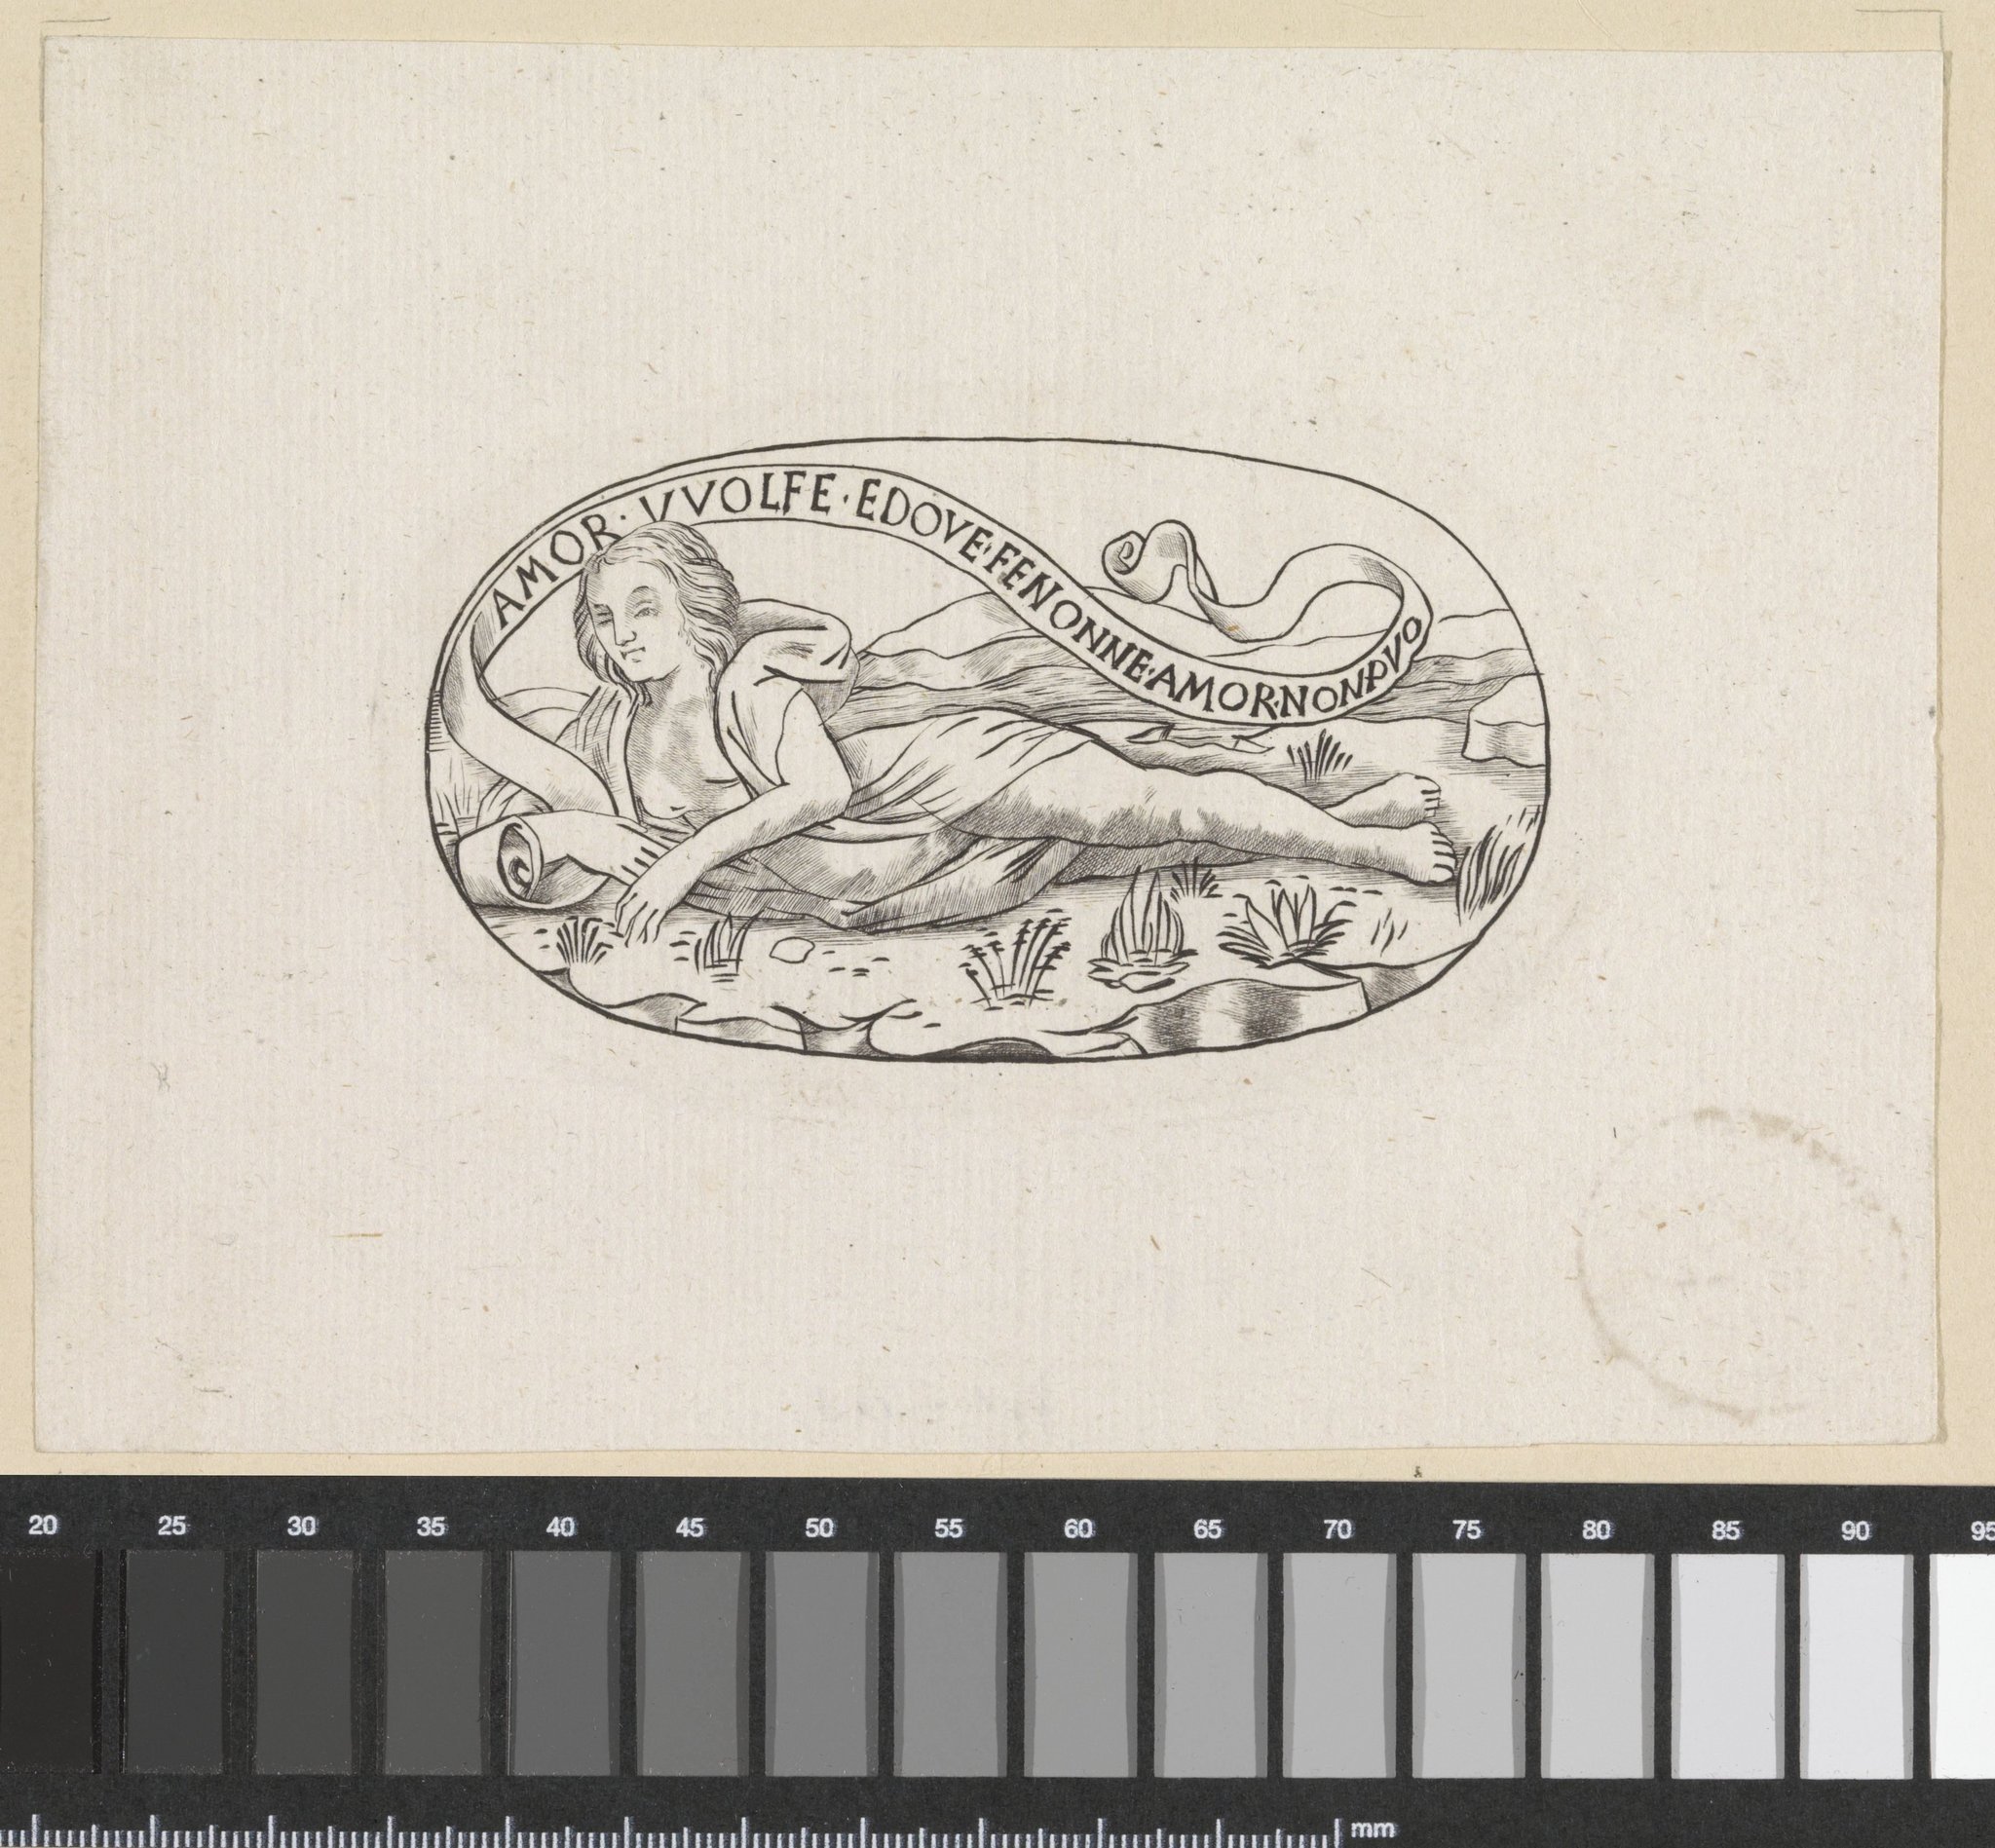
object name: print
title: Liggende vrouw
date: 1460-1485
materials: paper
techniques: engraving, etching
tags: adult woman, lying on one side, stretched out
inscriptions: collector's mark: Lugt 240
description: Een liggende vrouw met een banderol met de tekst: amore vvolfe edove fenonne amor nonpvo.